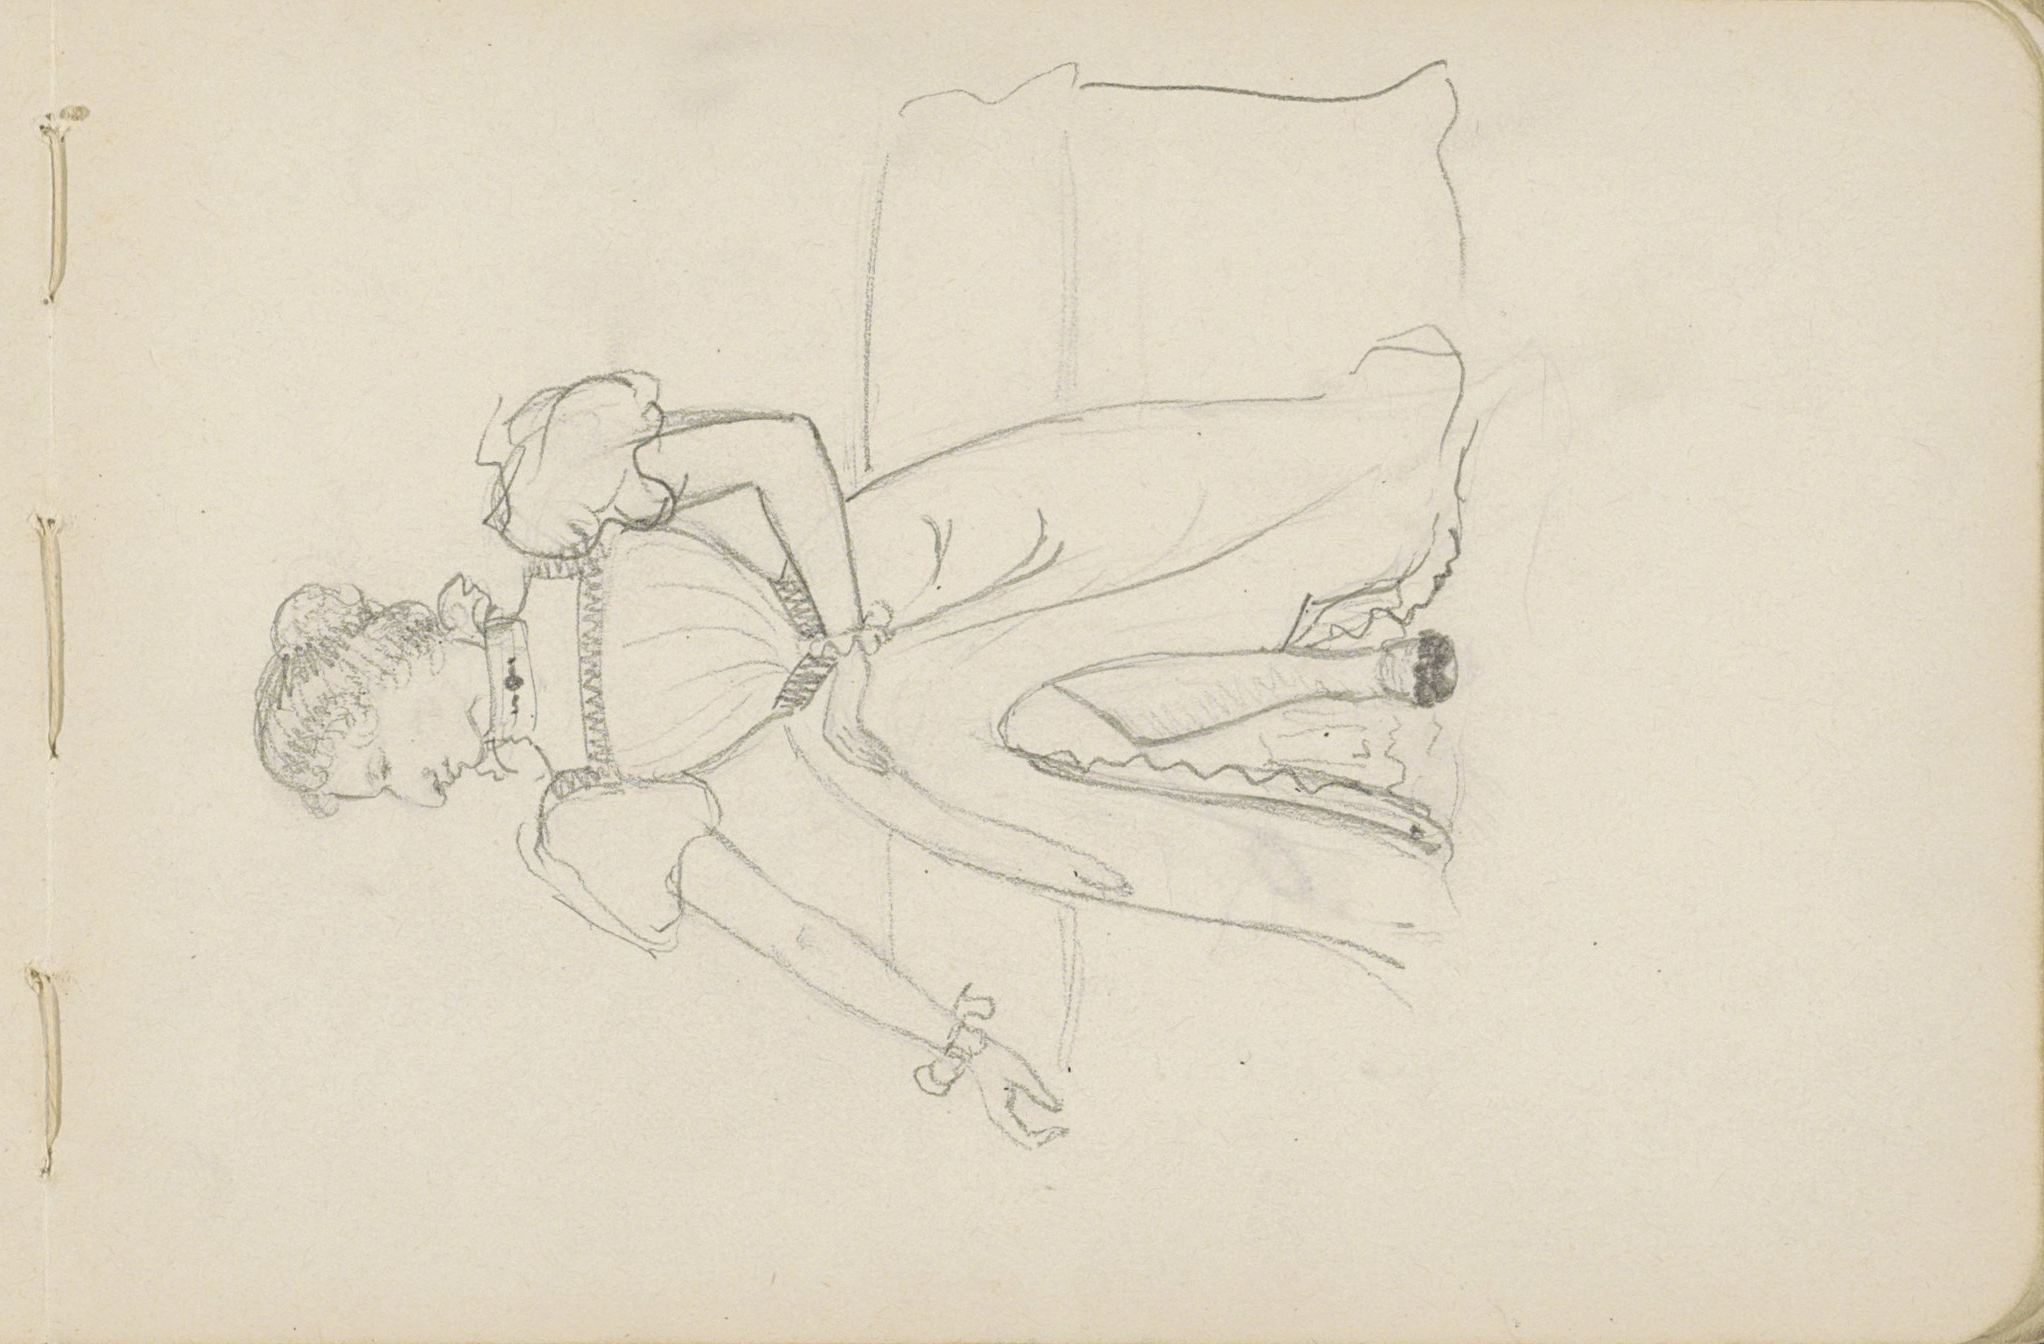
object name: sketchbook leaf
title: Vrouw zittend op een bank in een jurk met pofmouwen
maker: julie de graag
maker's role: draughtsman, print maker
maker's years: 1877-1924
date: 1894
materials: paper, pencil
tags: dress, gown: evening dress (+ women's clothes), sitting figure, adult woman, caricatures (human types)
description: De vrouw zit met de benen gekruist en heeft een karikaturale kop. Blad 4 recto uit een schetsboek met 35 bladen.